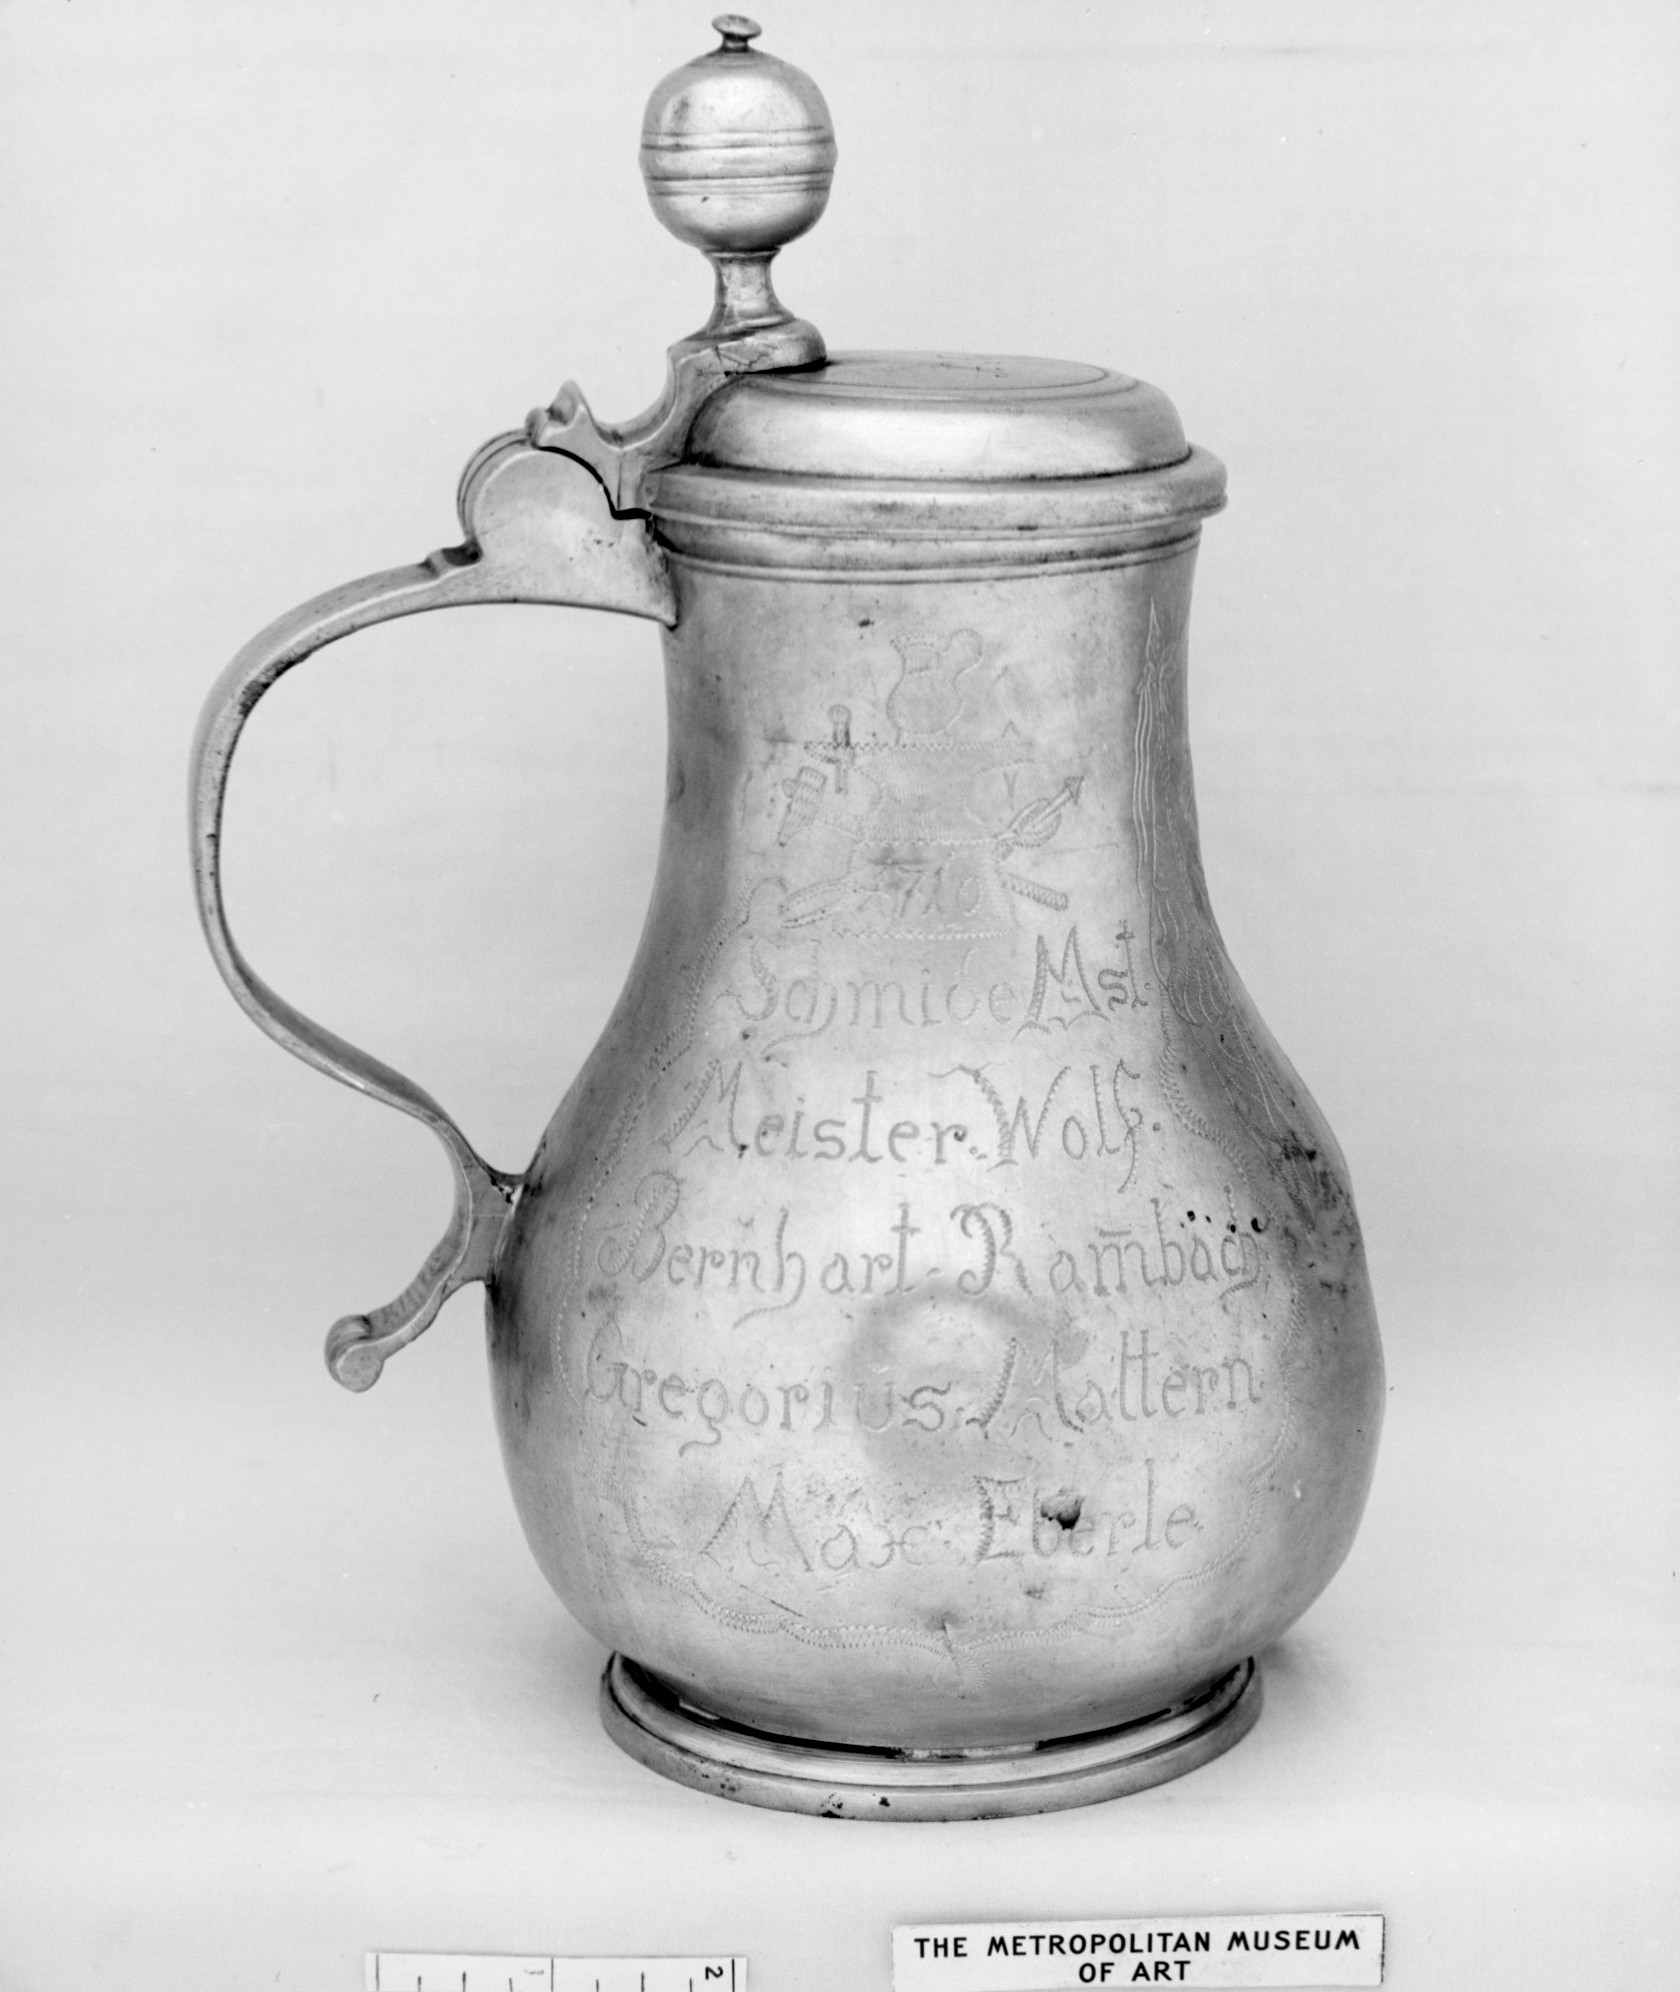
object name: flagon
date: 1701-1733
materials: pewter